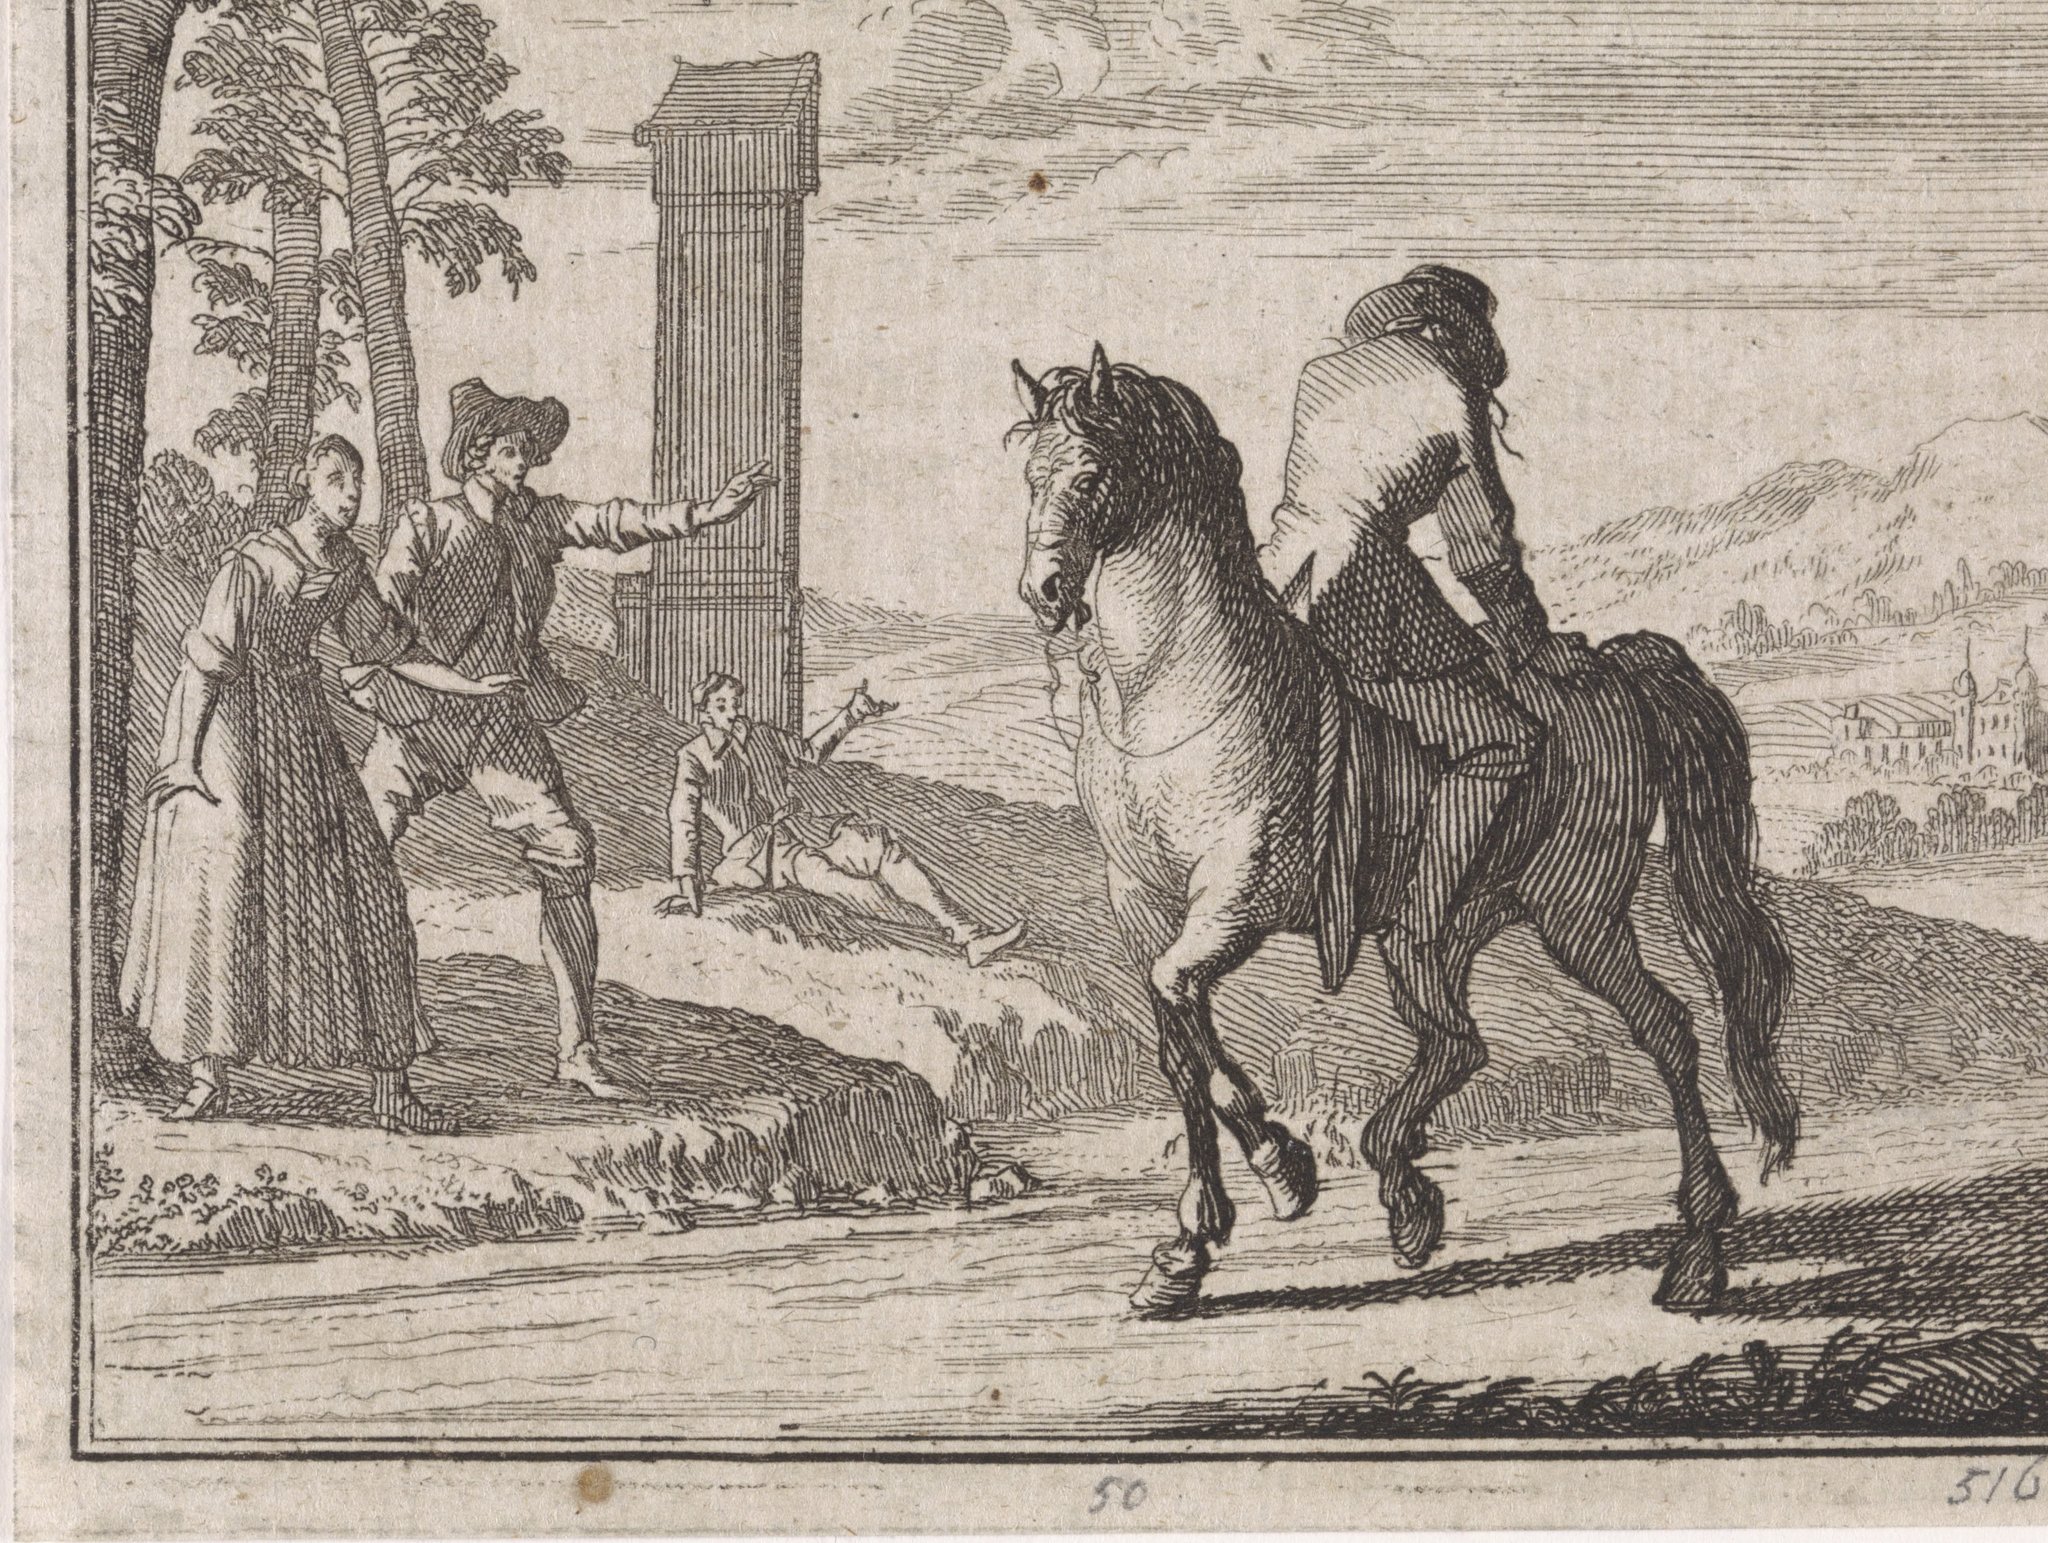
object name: print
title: Krankzinnig geworden edelman zit achterstevoren op een paard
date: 1704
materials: paper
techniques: etching, letterpress printing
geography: nuremberg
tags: riding a horse, ass, or mule; rider, horseman, emotional illness, derangement, madness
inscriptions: collector's mark: Lugt 2228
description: Illustratie uit: Abraham a Sancta Clara. Heilsames Gemisch Gemasch, das ist: Allerley seltsame und verwunderliche Geschichten (...). Neurenberg: Christoph Weigel, 1704, p. 516.